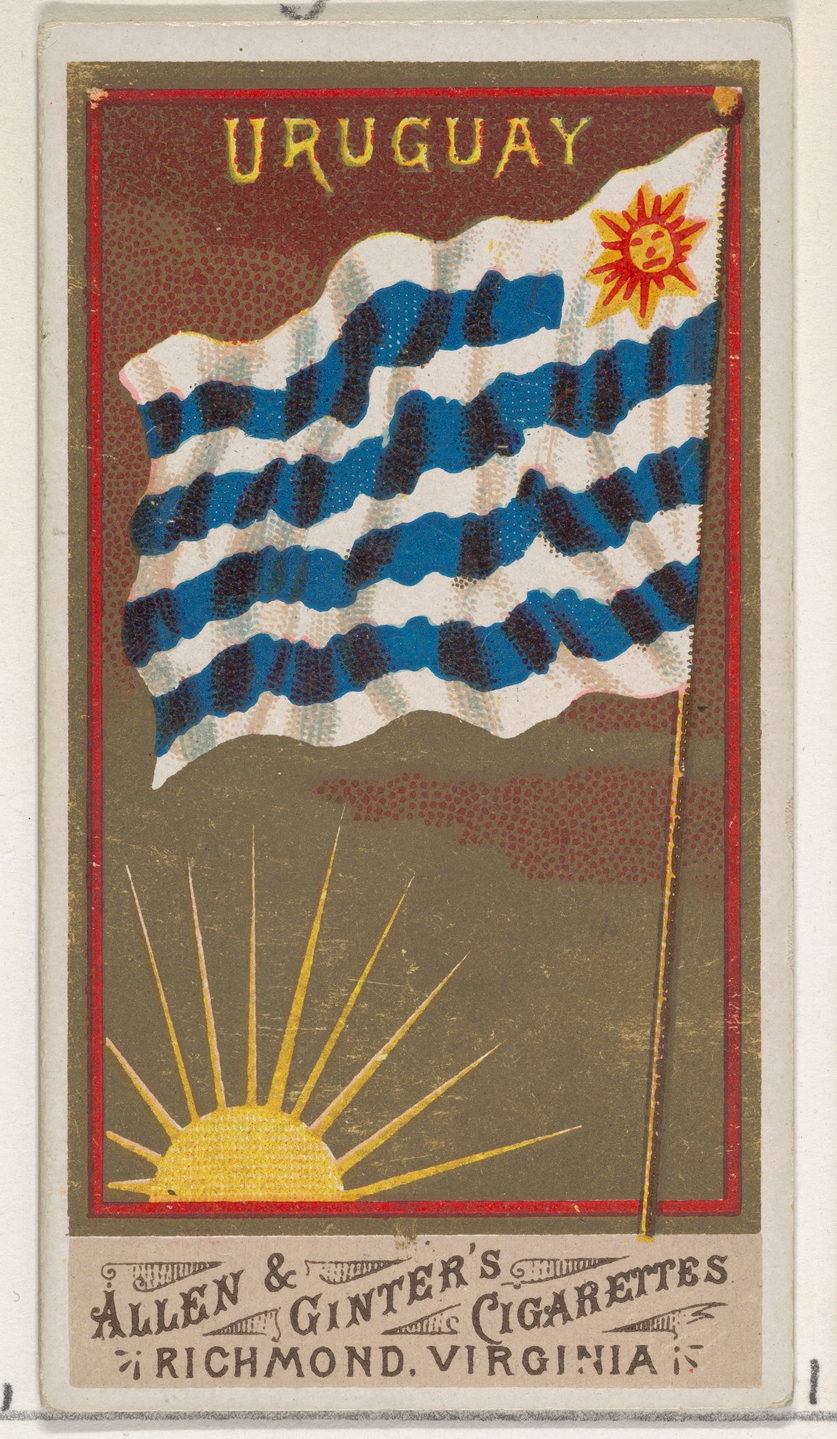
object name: print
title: Uruguay, from Flags of All Nations, Series 1 (N9) for Allen & Ginter Cigarettes Brands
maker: allen & ginter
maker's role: publisher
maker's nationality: american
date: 1887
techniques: color lithograph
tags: flags